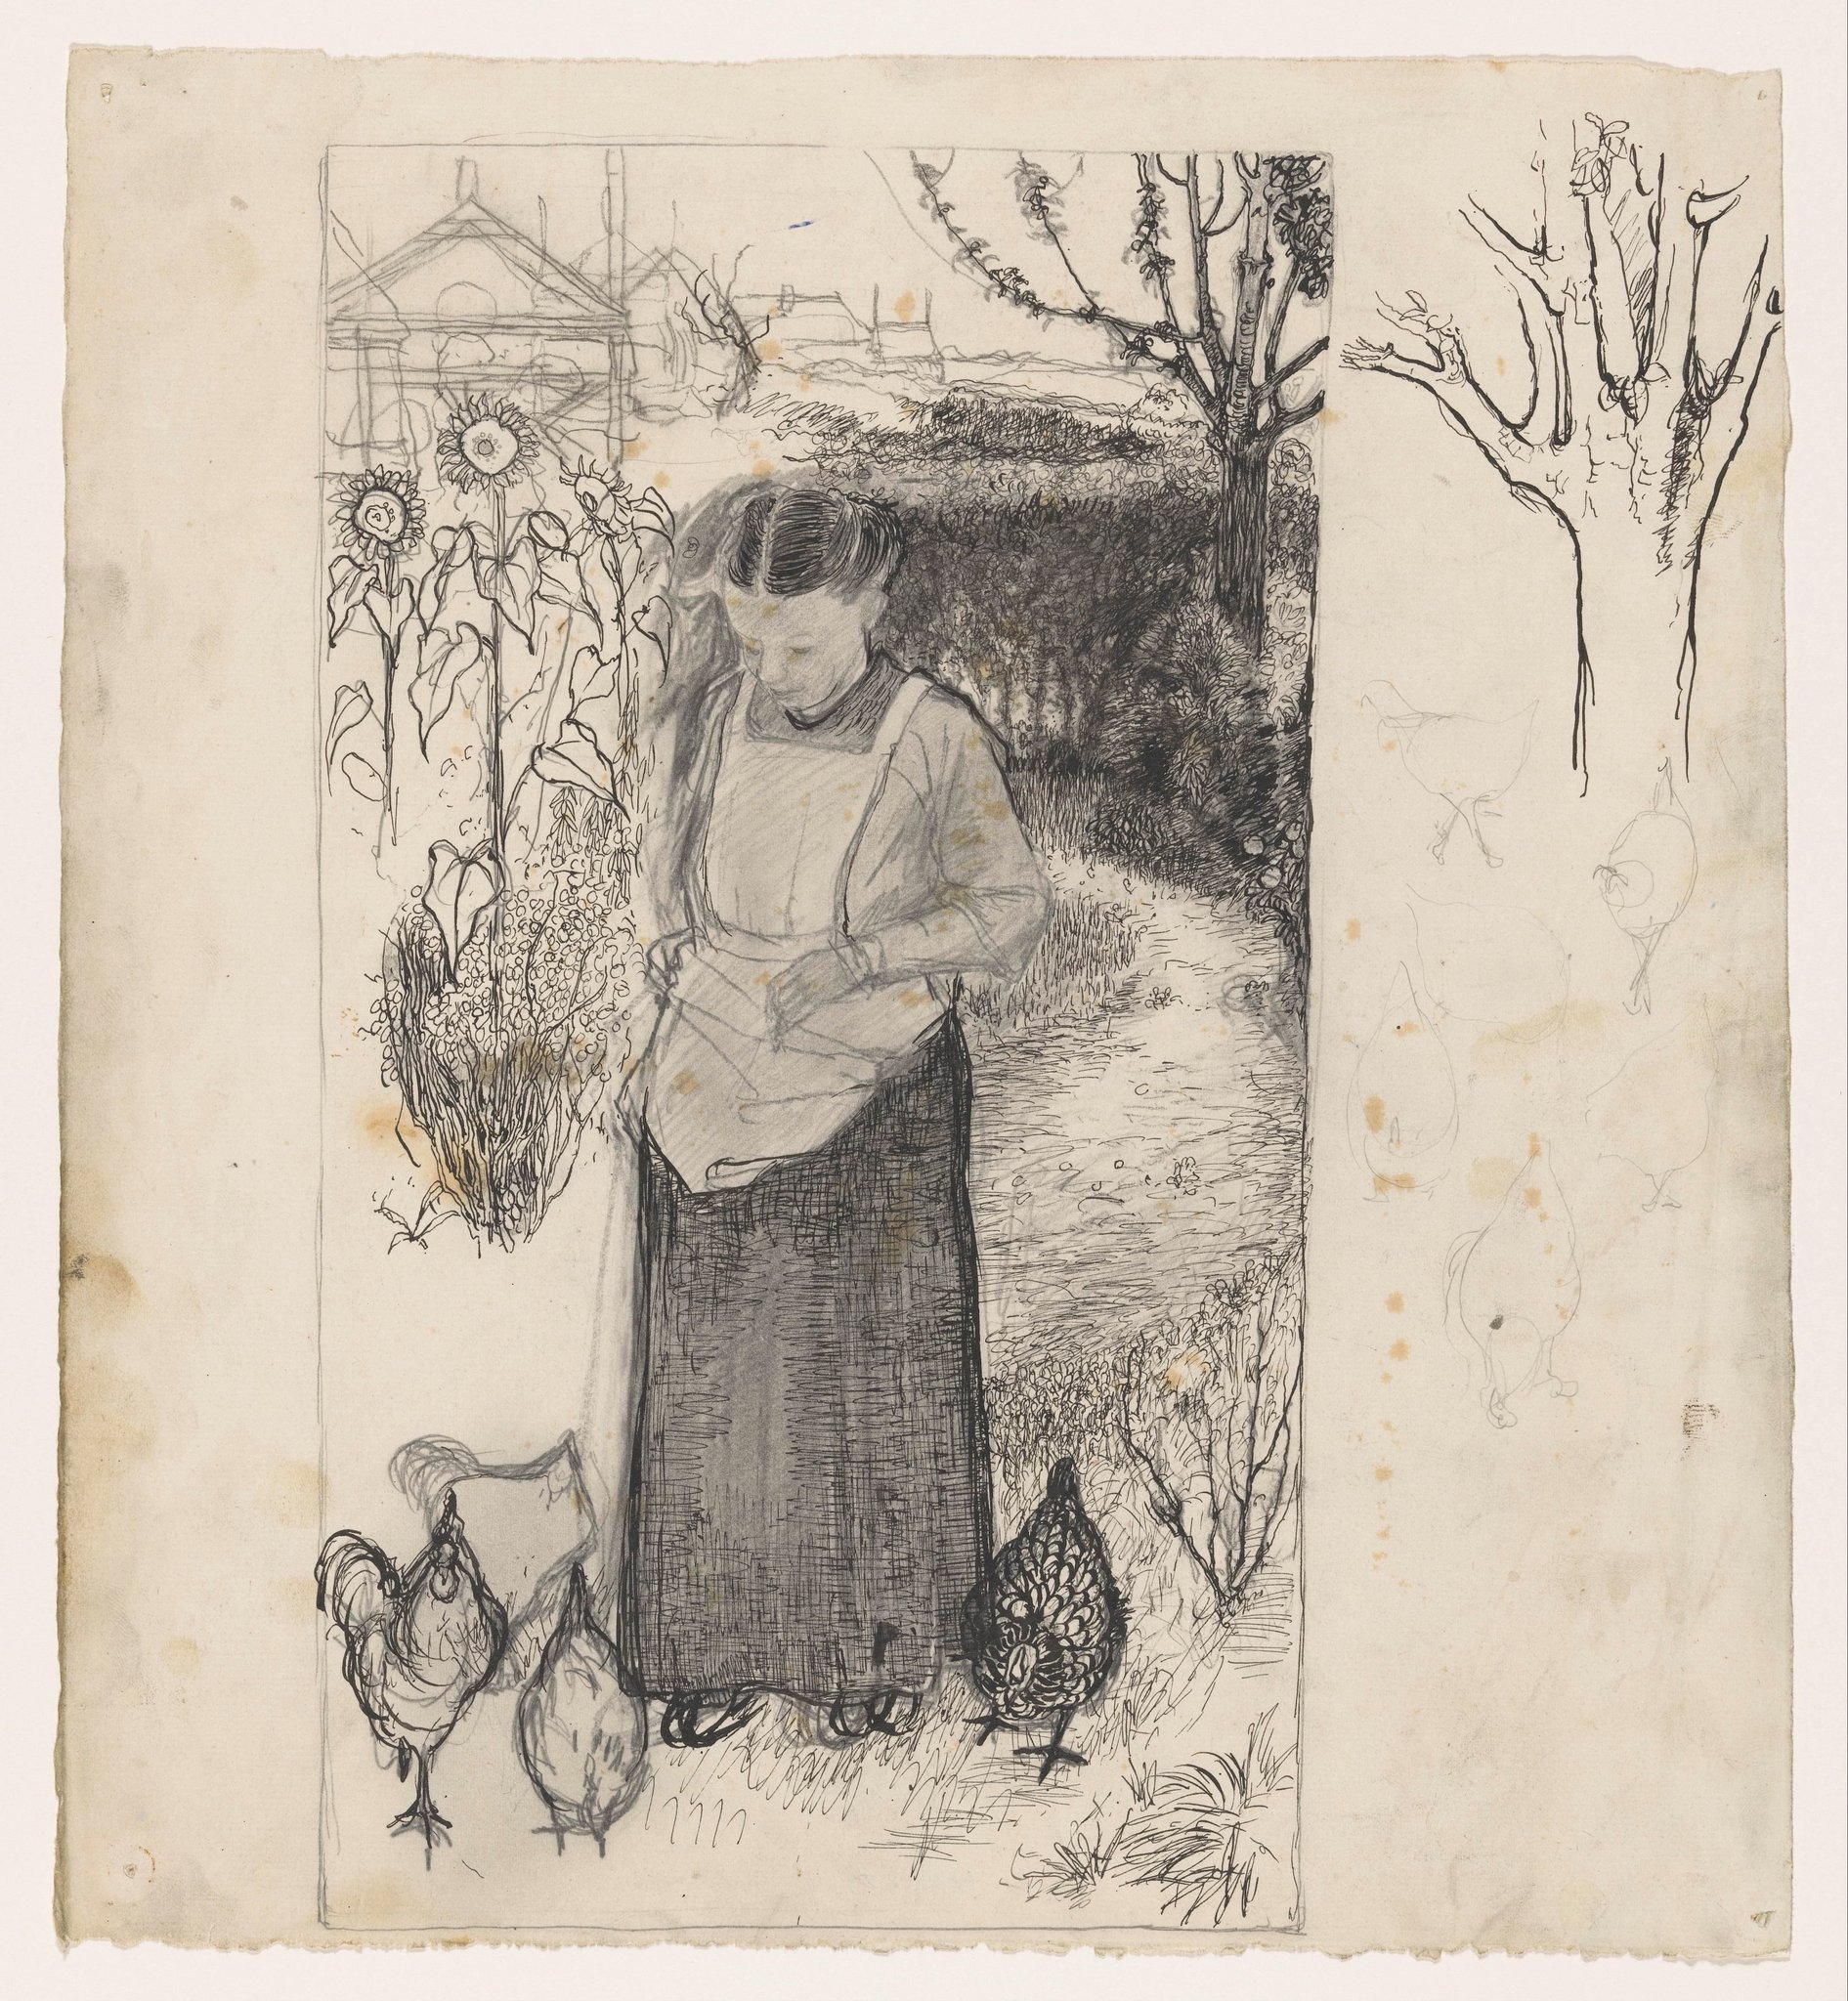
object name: drawing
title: Anne Mankes-Zernike voert kippen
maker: jan mankes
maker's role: draughtsman, painter, print maker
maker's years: 1889-1920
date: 1899-1920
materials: chalk, ink, paper, pencil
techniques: pen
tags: amsterdam, anne mankes-zernike, historical persons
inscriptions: collector's mark: Lugt 2228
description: Anne Mankes-Zernike is de vrouw van de kunstenaar.